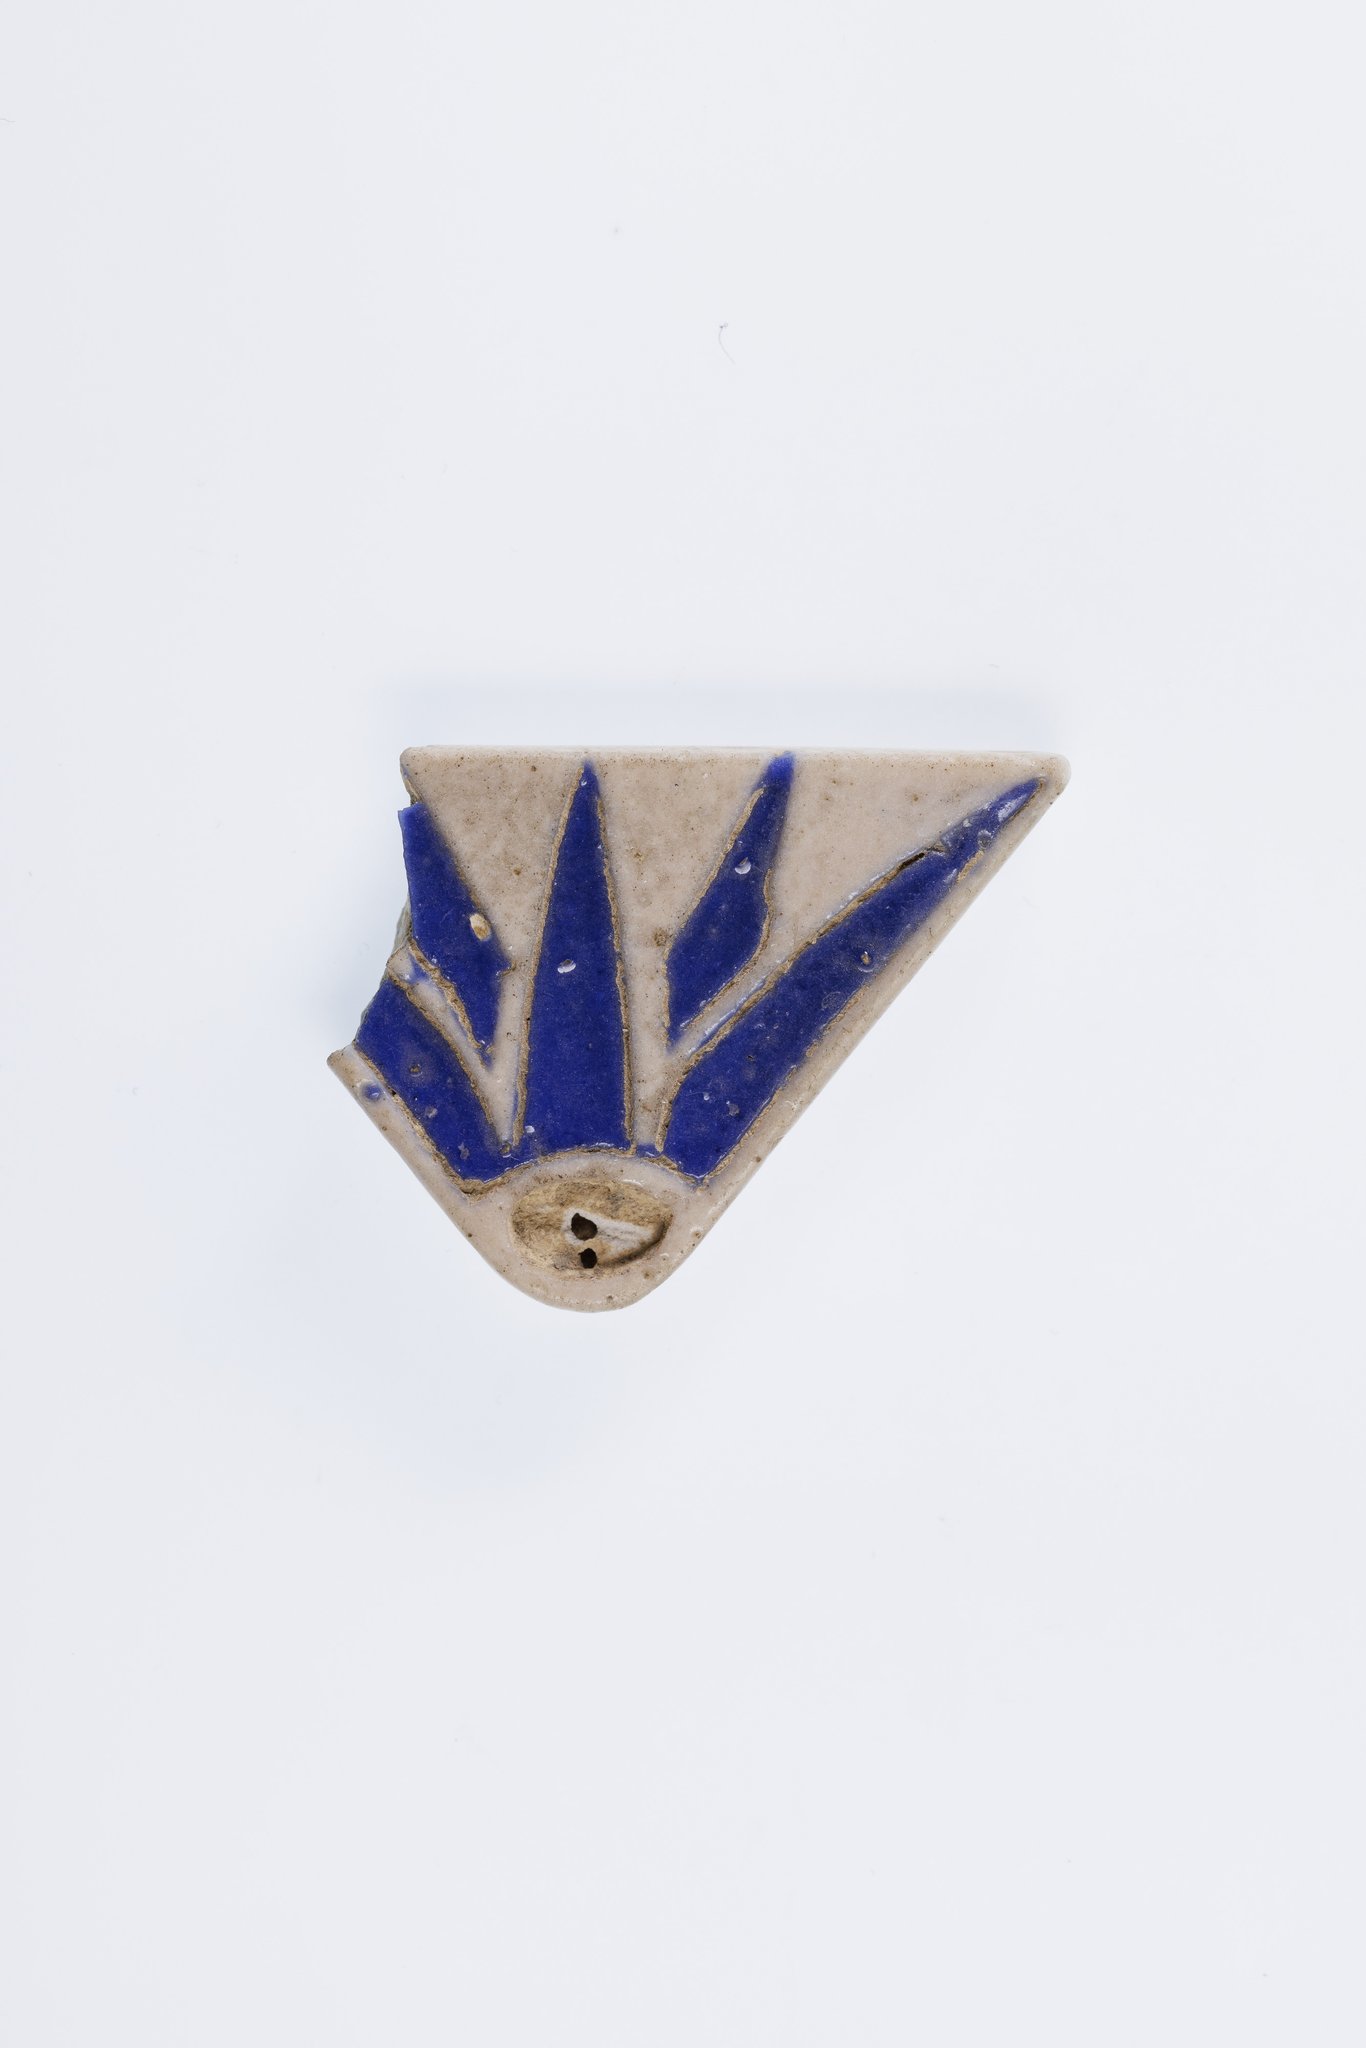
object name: terminal, lotus flower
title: Lotus terminal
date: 1353-1336 BCE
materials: faience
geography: egypt